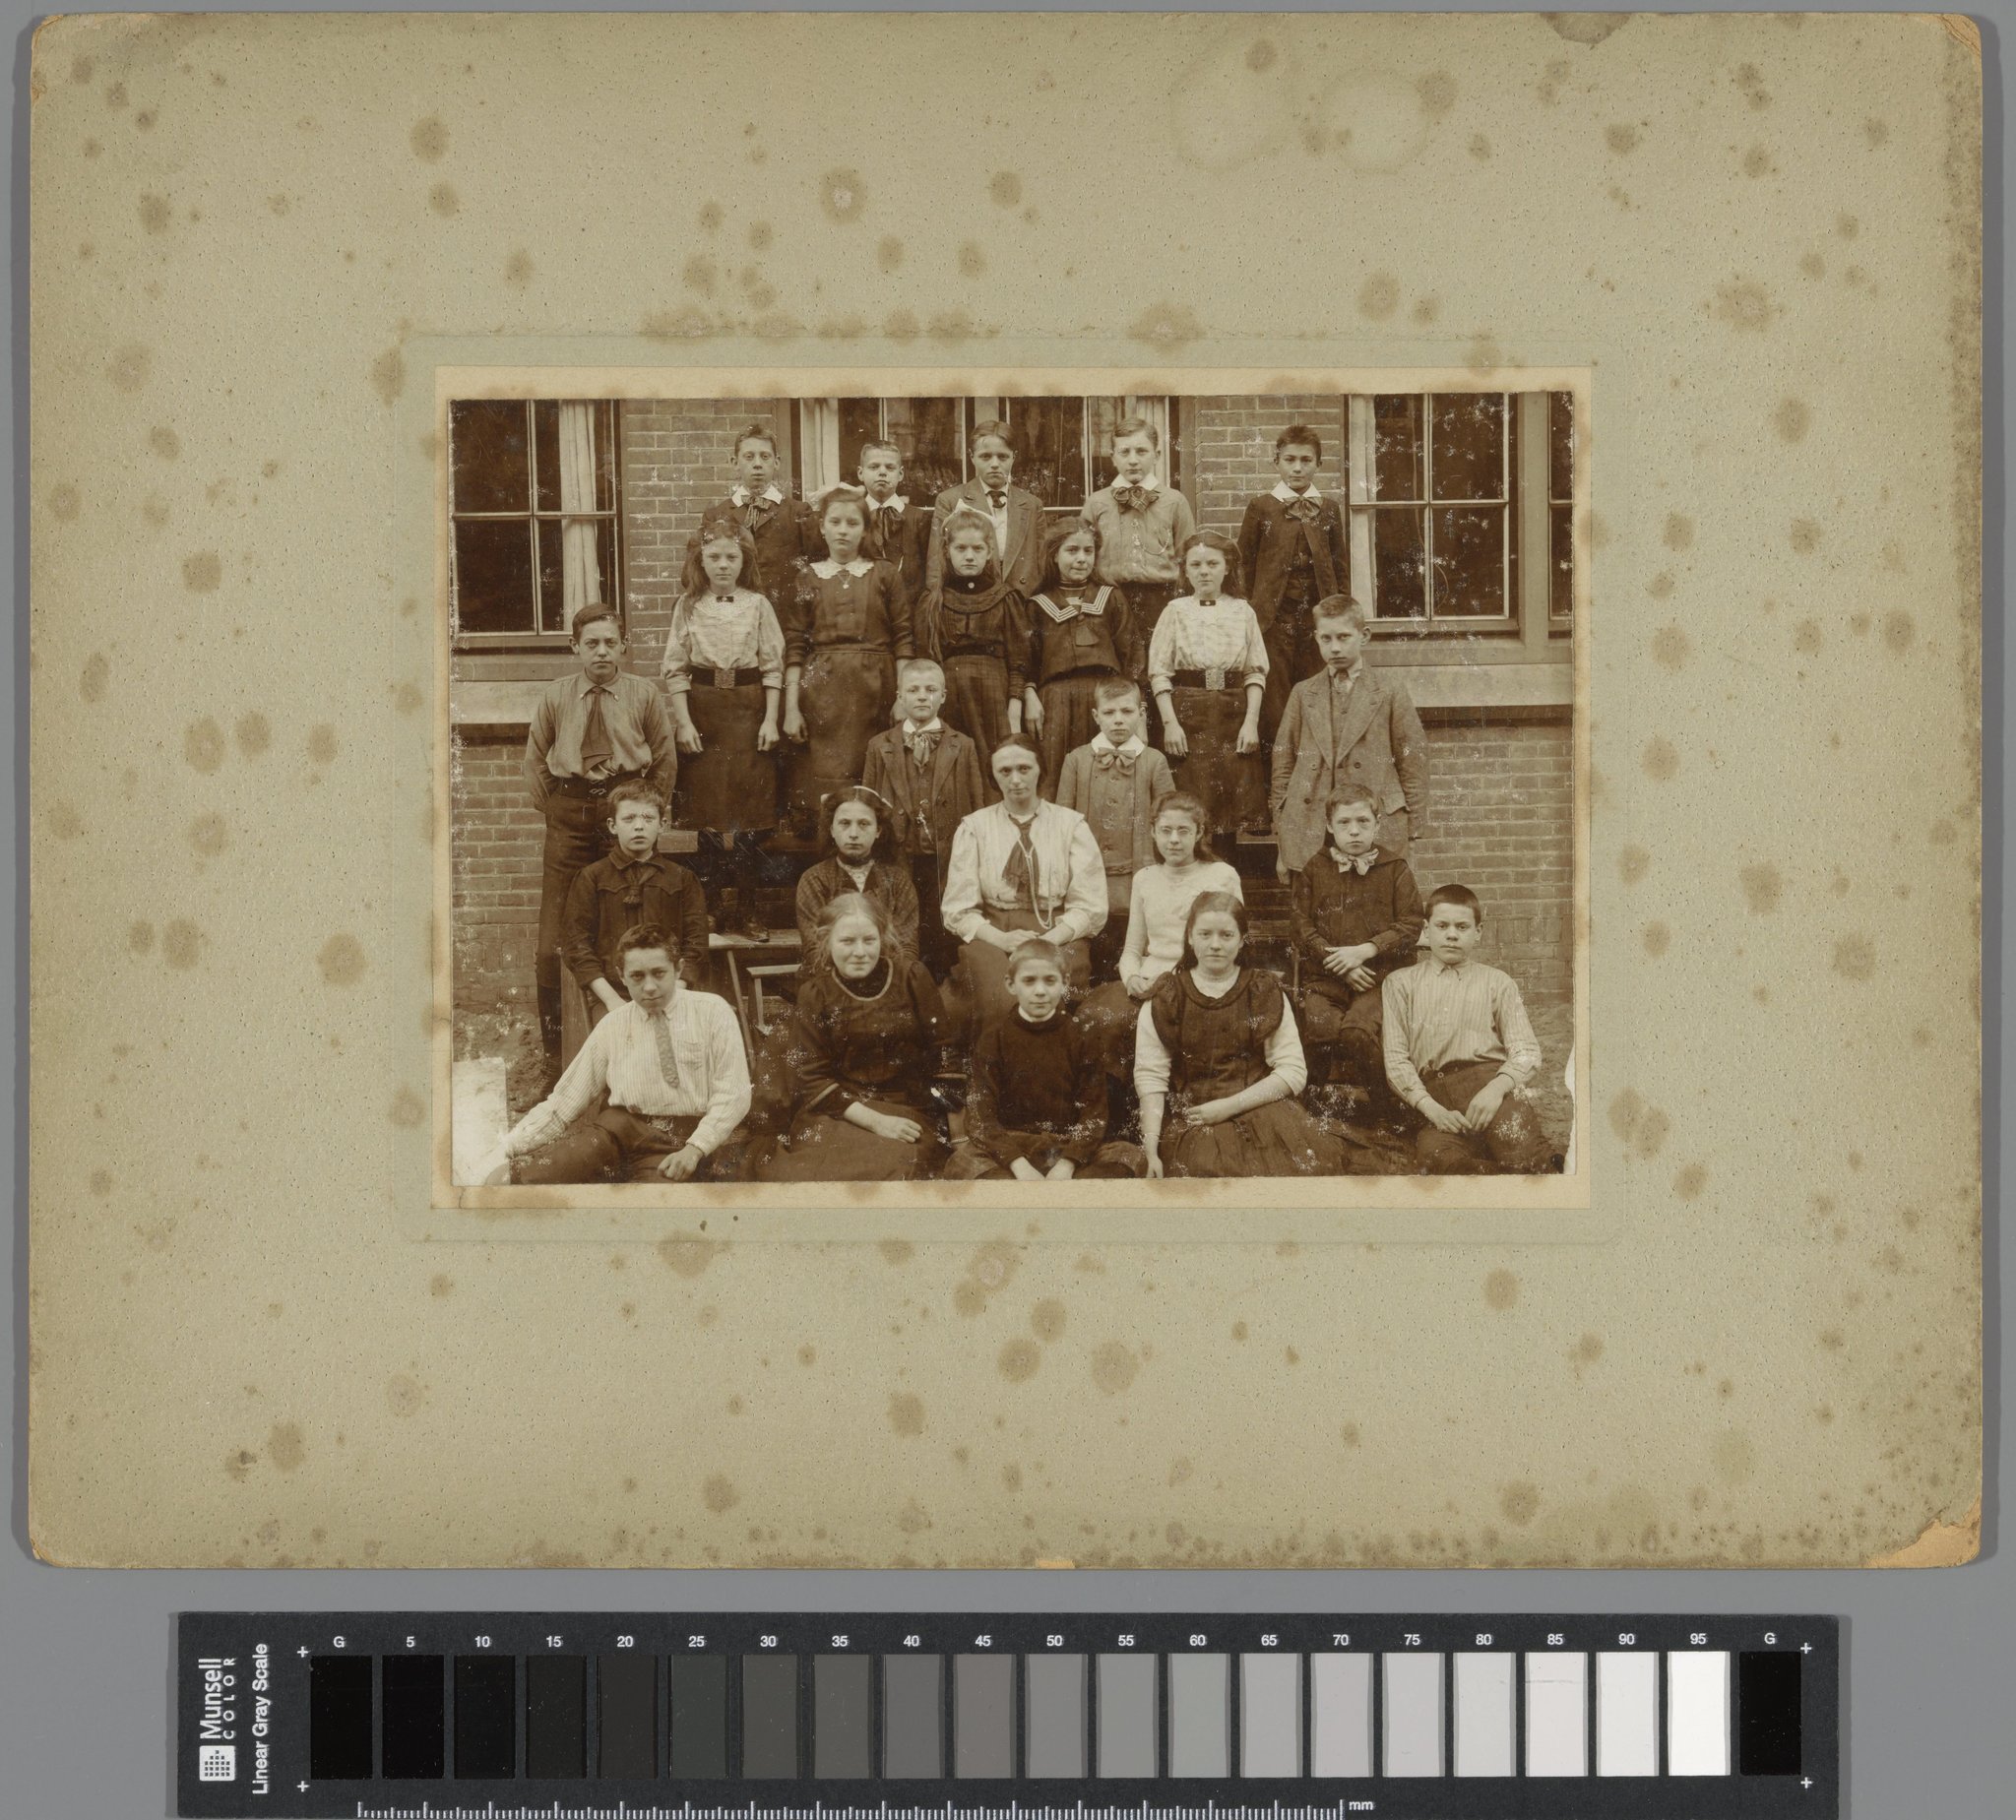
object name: photograph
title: Schoolfoto van een klas rondom juf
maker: Anonymous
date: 1905-1915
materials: cardboard, photographic support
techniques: collodion silver print